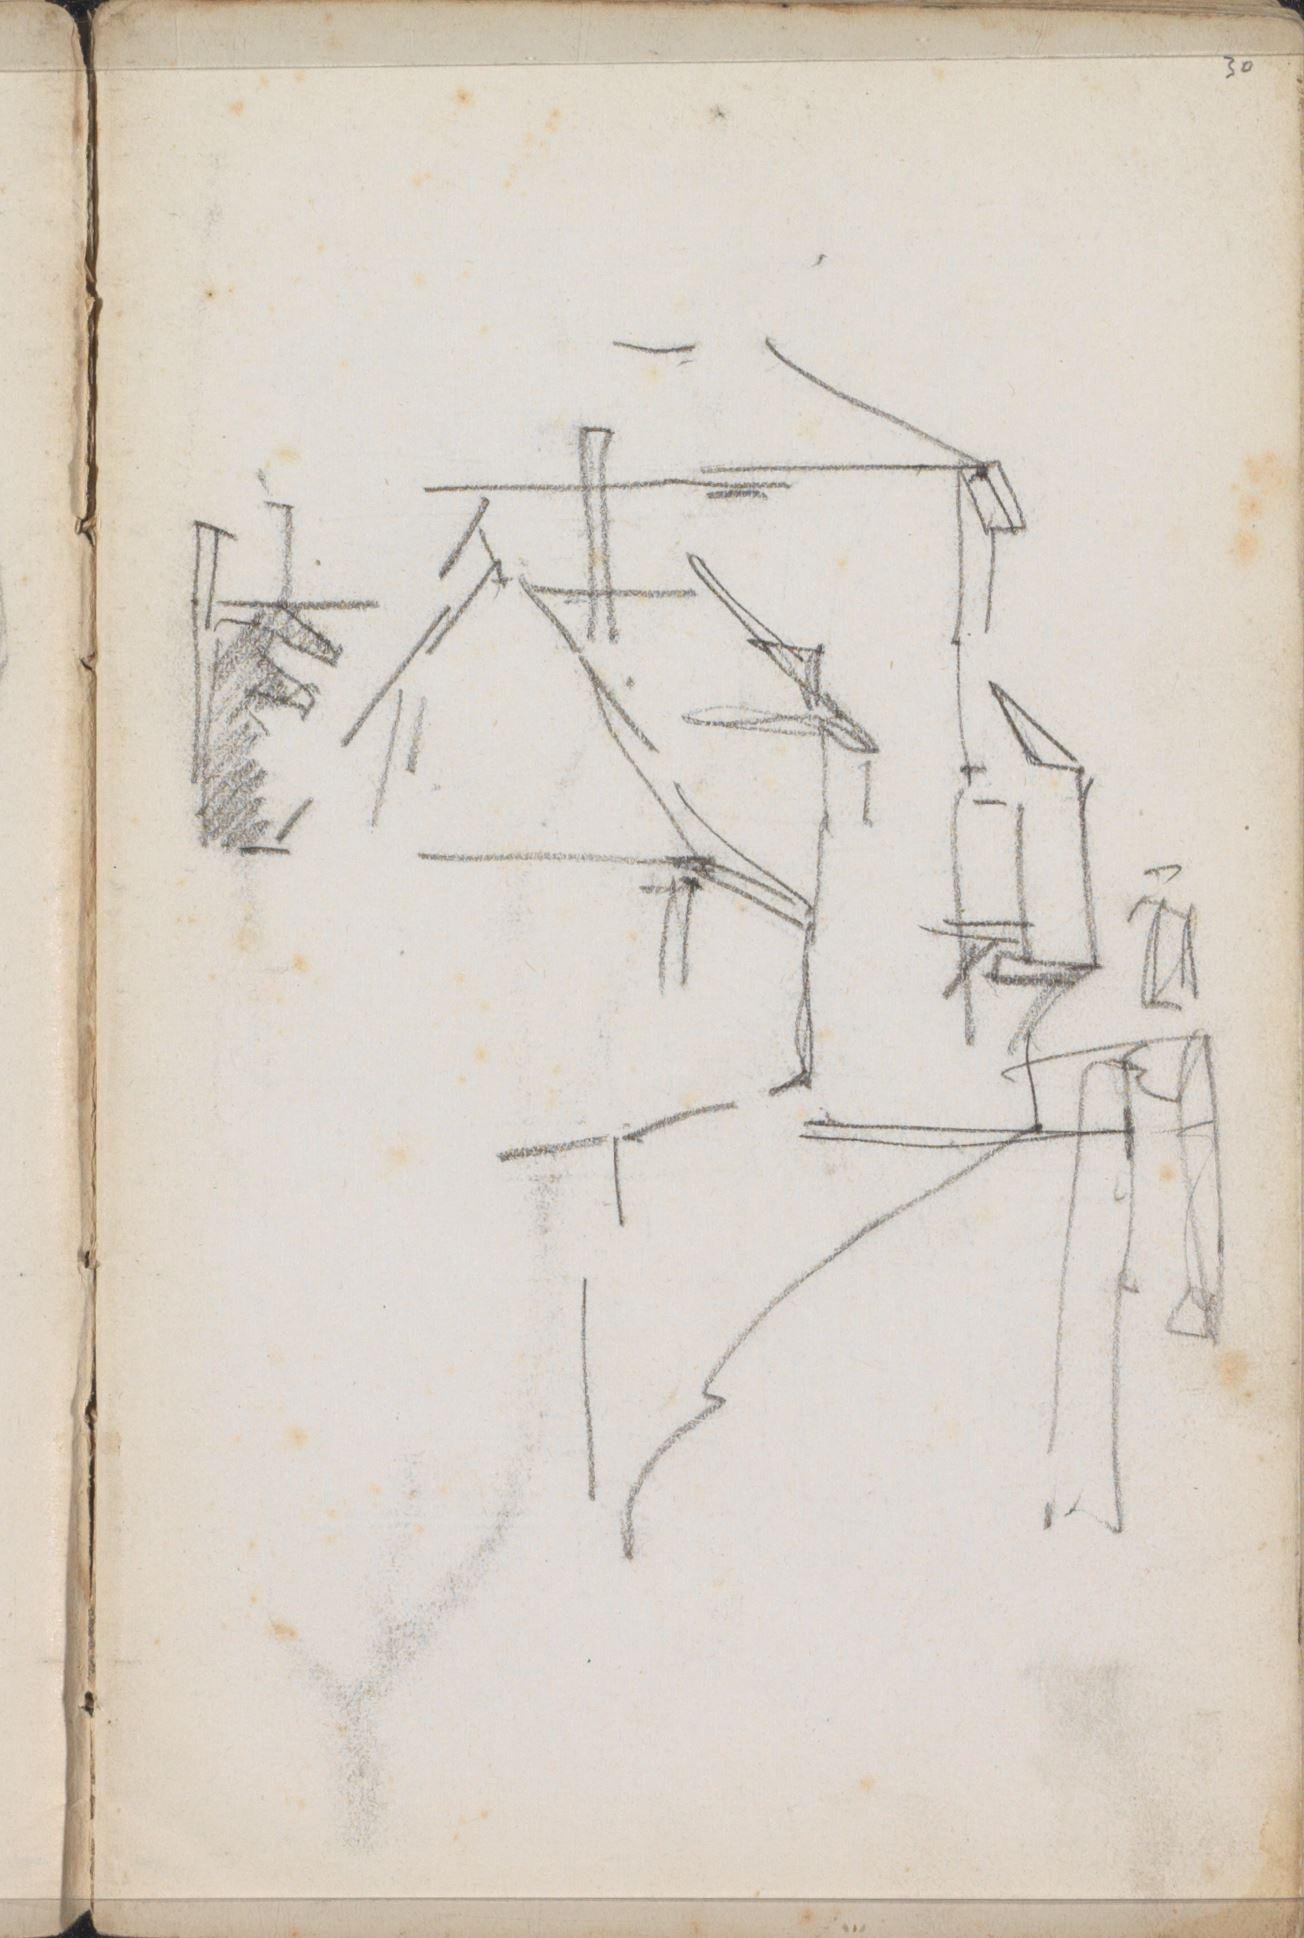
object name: sketchbook leaf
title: Gezicht op gebouwen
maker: george hendrik breitner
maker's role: draughtsman, painter, print maker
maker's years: 1857-1923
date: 1880-1882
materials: chalk, paper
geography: south holland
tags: civic architecture; edifices; dwellings, street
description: Vooraan een figuur. Pagina 30 uit een schetsboek met 72 bladen.